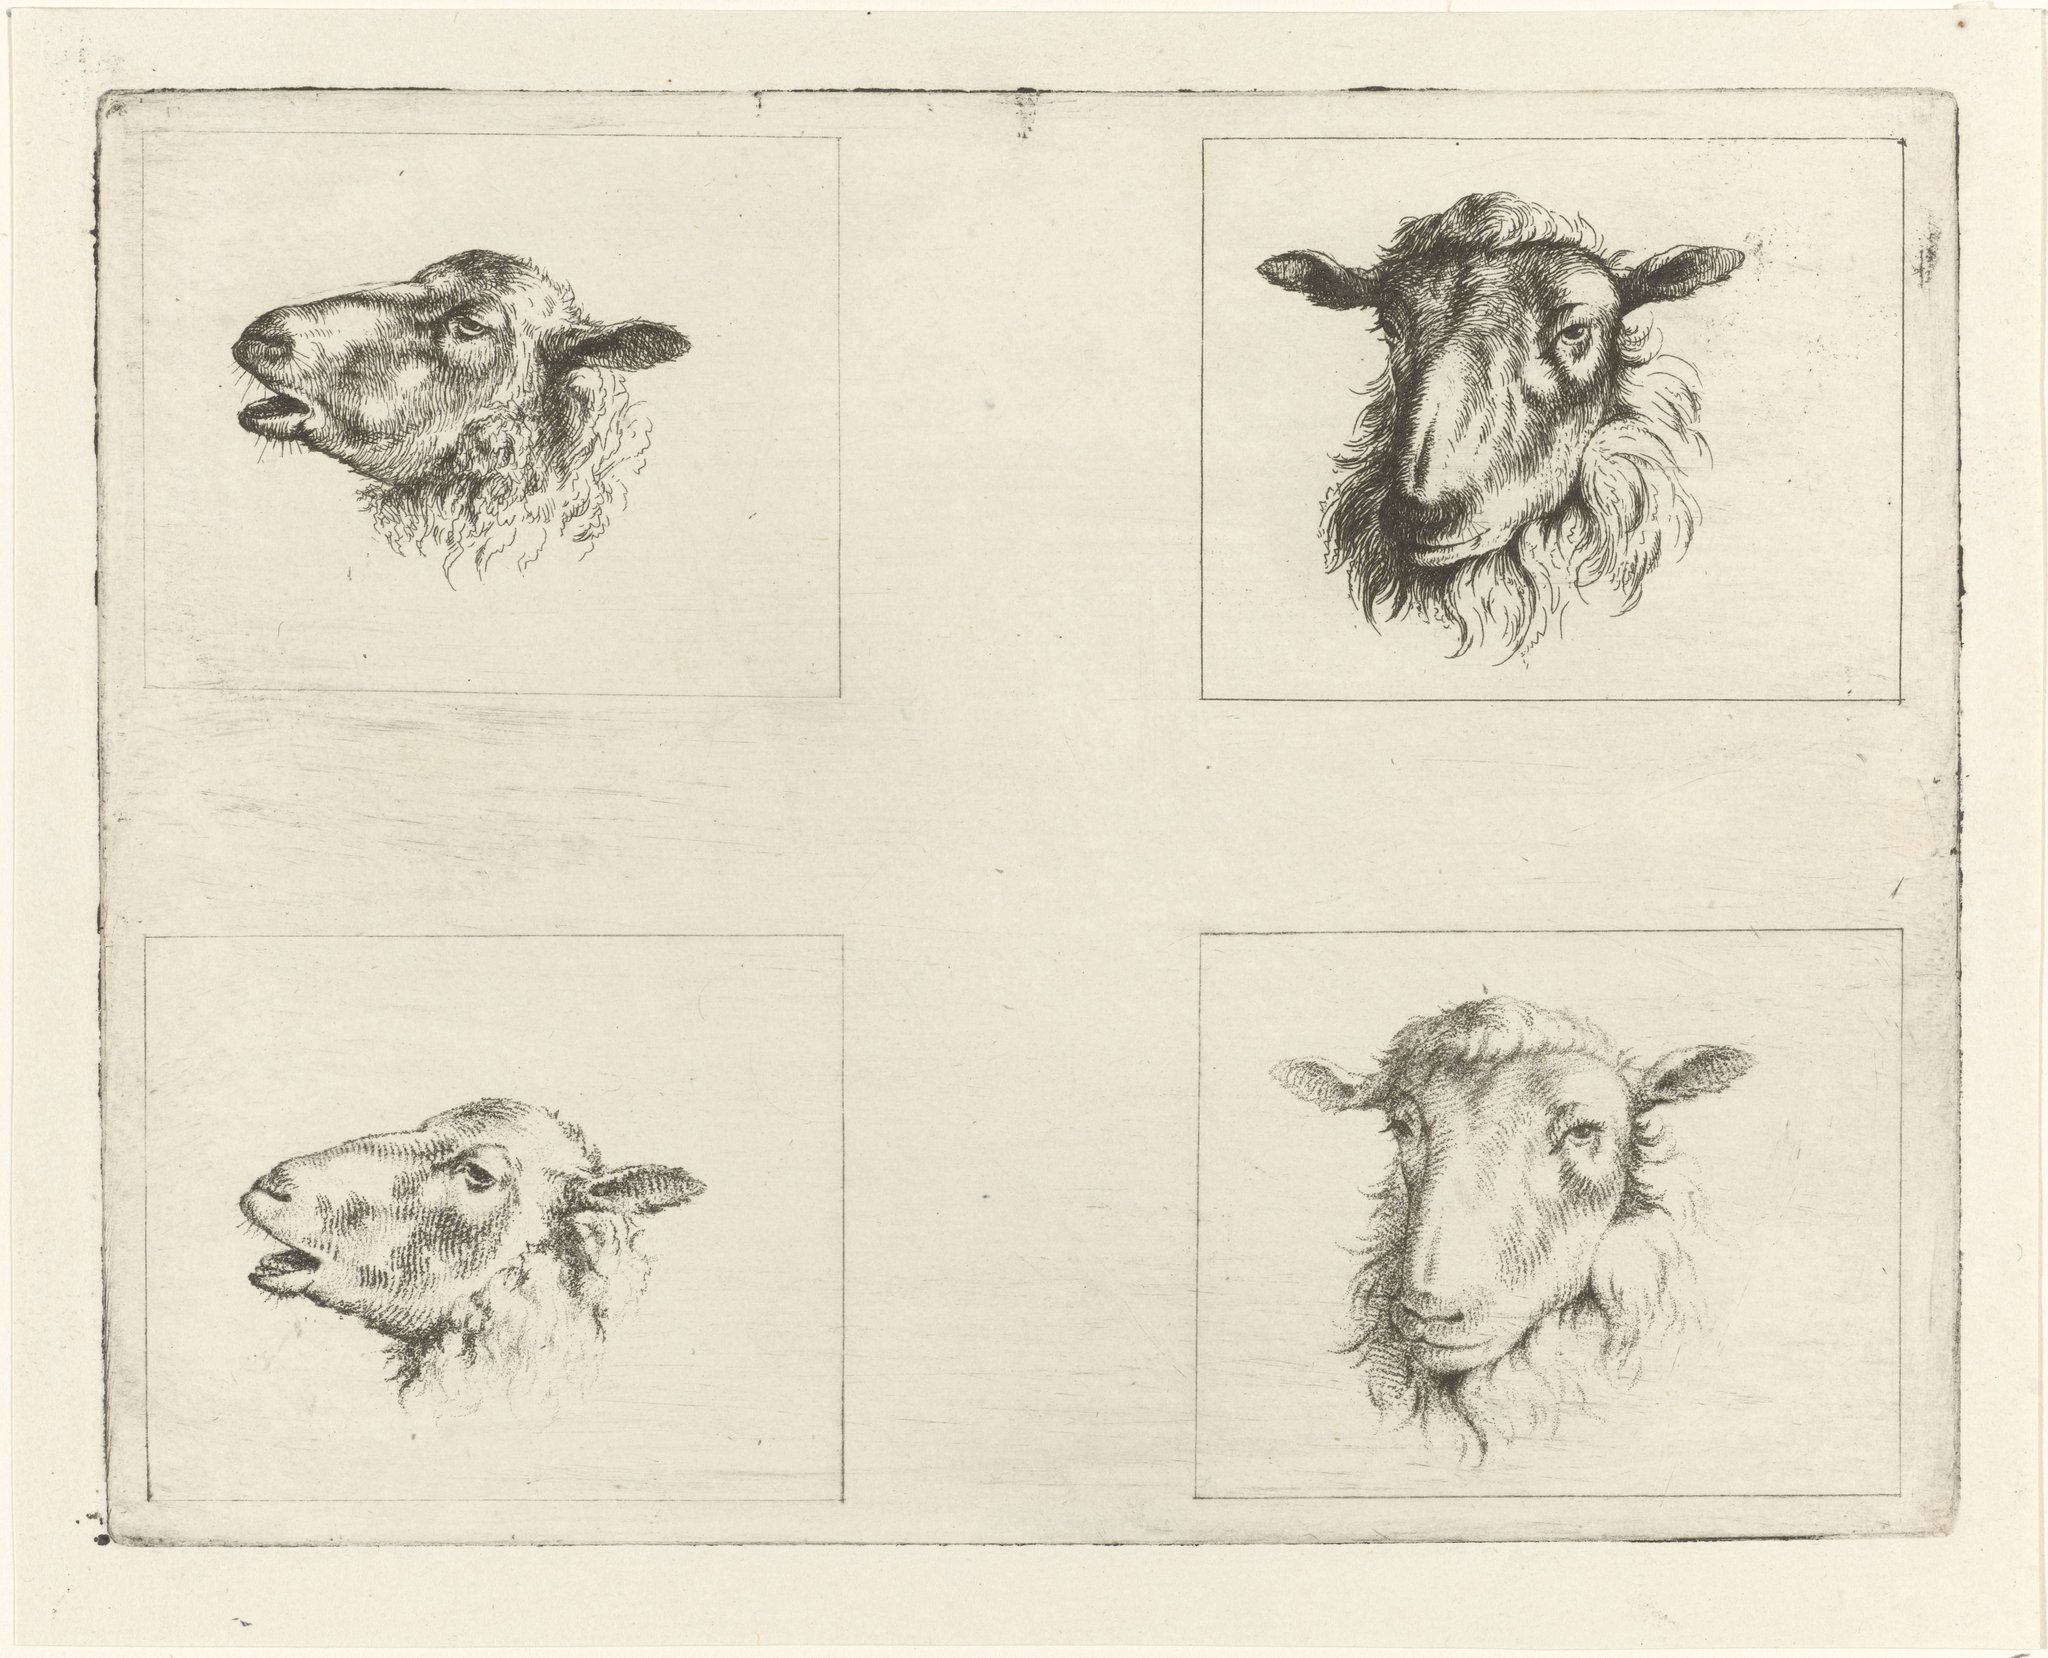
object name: print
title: Studieblad met vier schapenkoppen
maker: johannes janson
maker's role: draughtsman, painter, print maker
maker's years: 1729-1784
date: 1761-1784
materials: paper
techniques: etching, soft ground etching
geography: leiden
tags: sheep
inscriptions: collector's mark: Lugt 2228